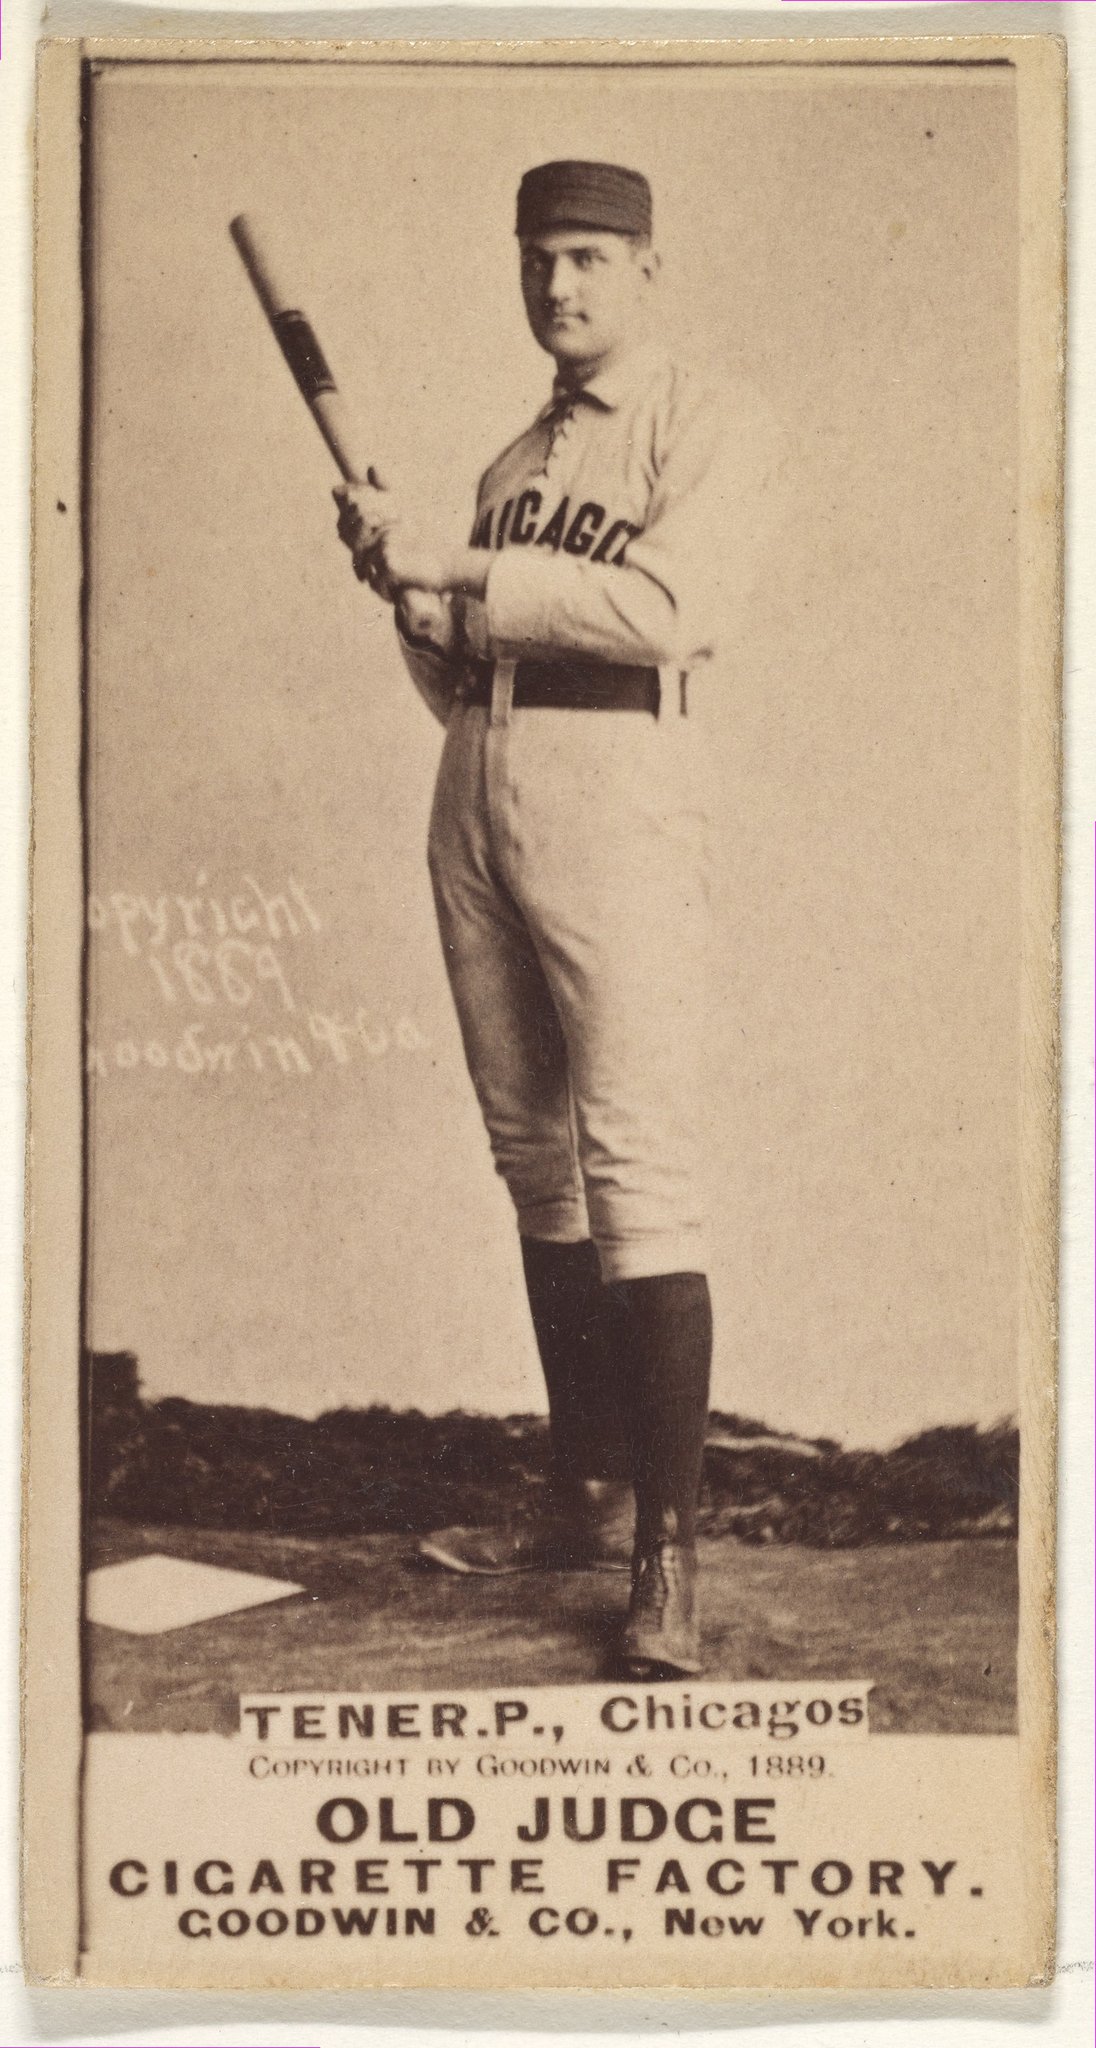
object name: baseball card, photograph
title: Tener, Pitcher, Chicago, from the Old Judge series (N172) for Old Judge Cigarettes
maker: goodwin & company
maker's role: publisher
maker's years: 1850-1950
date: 1889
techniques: albumen silver print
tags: men,portraits,baseball,athletes